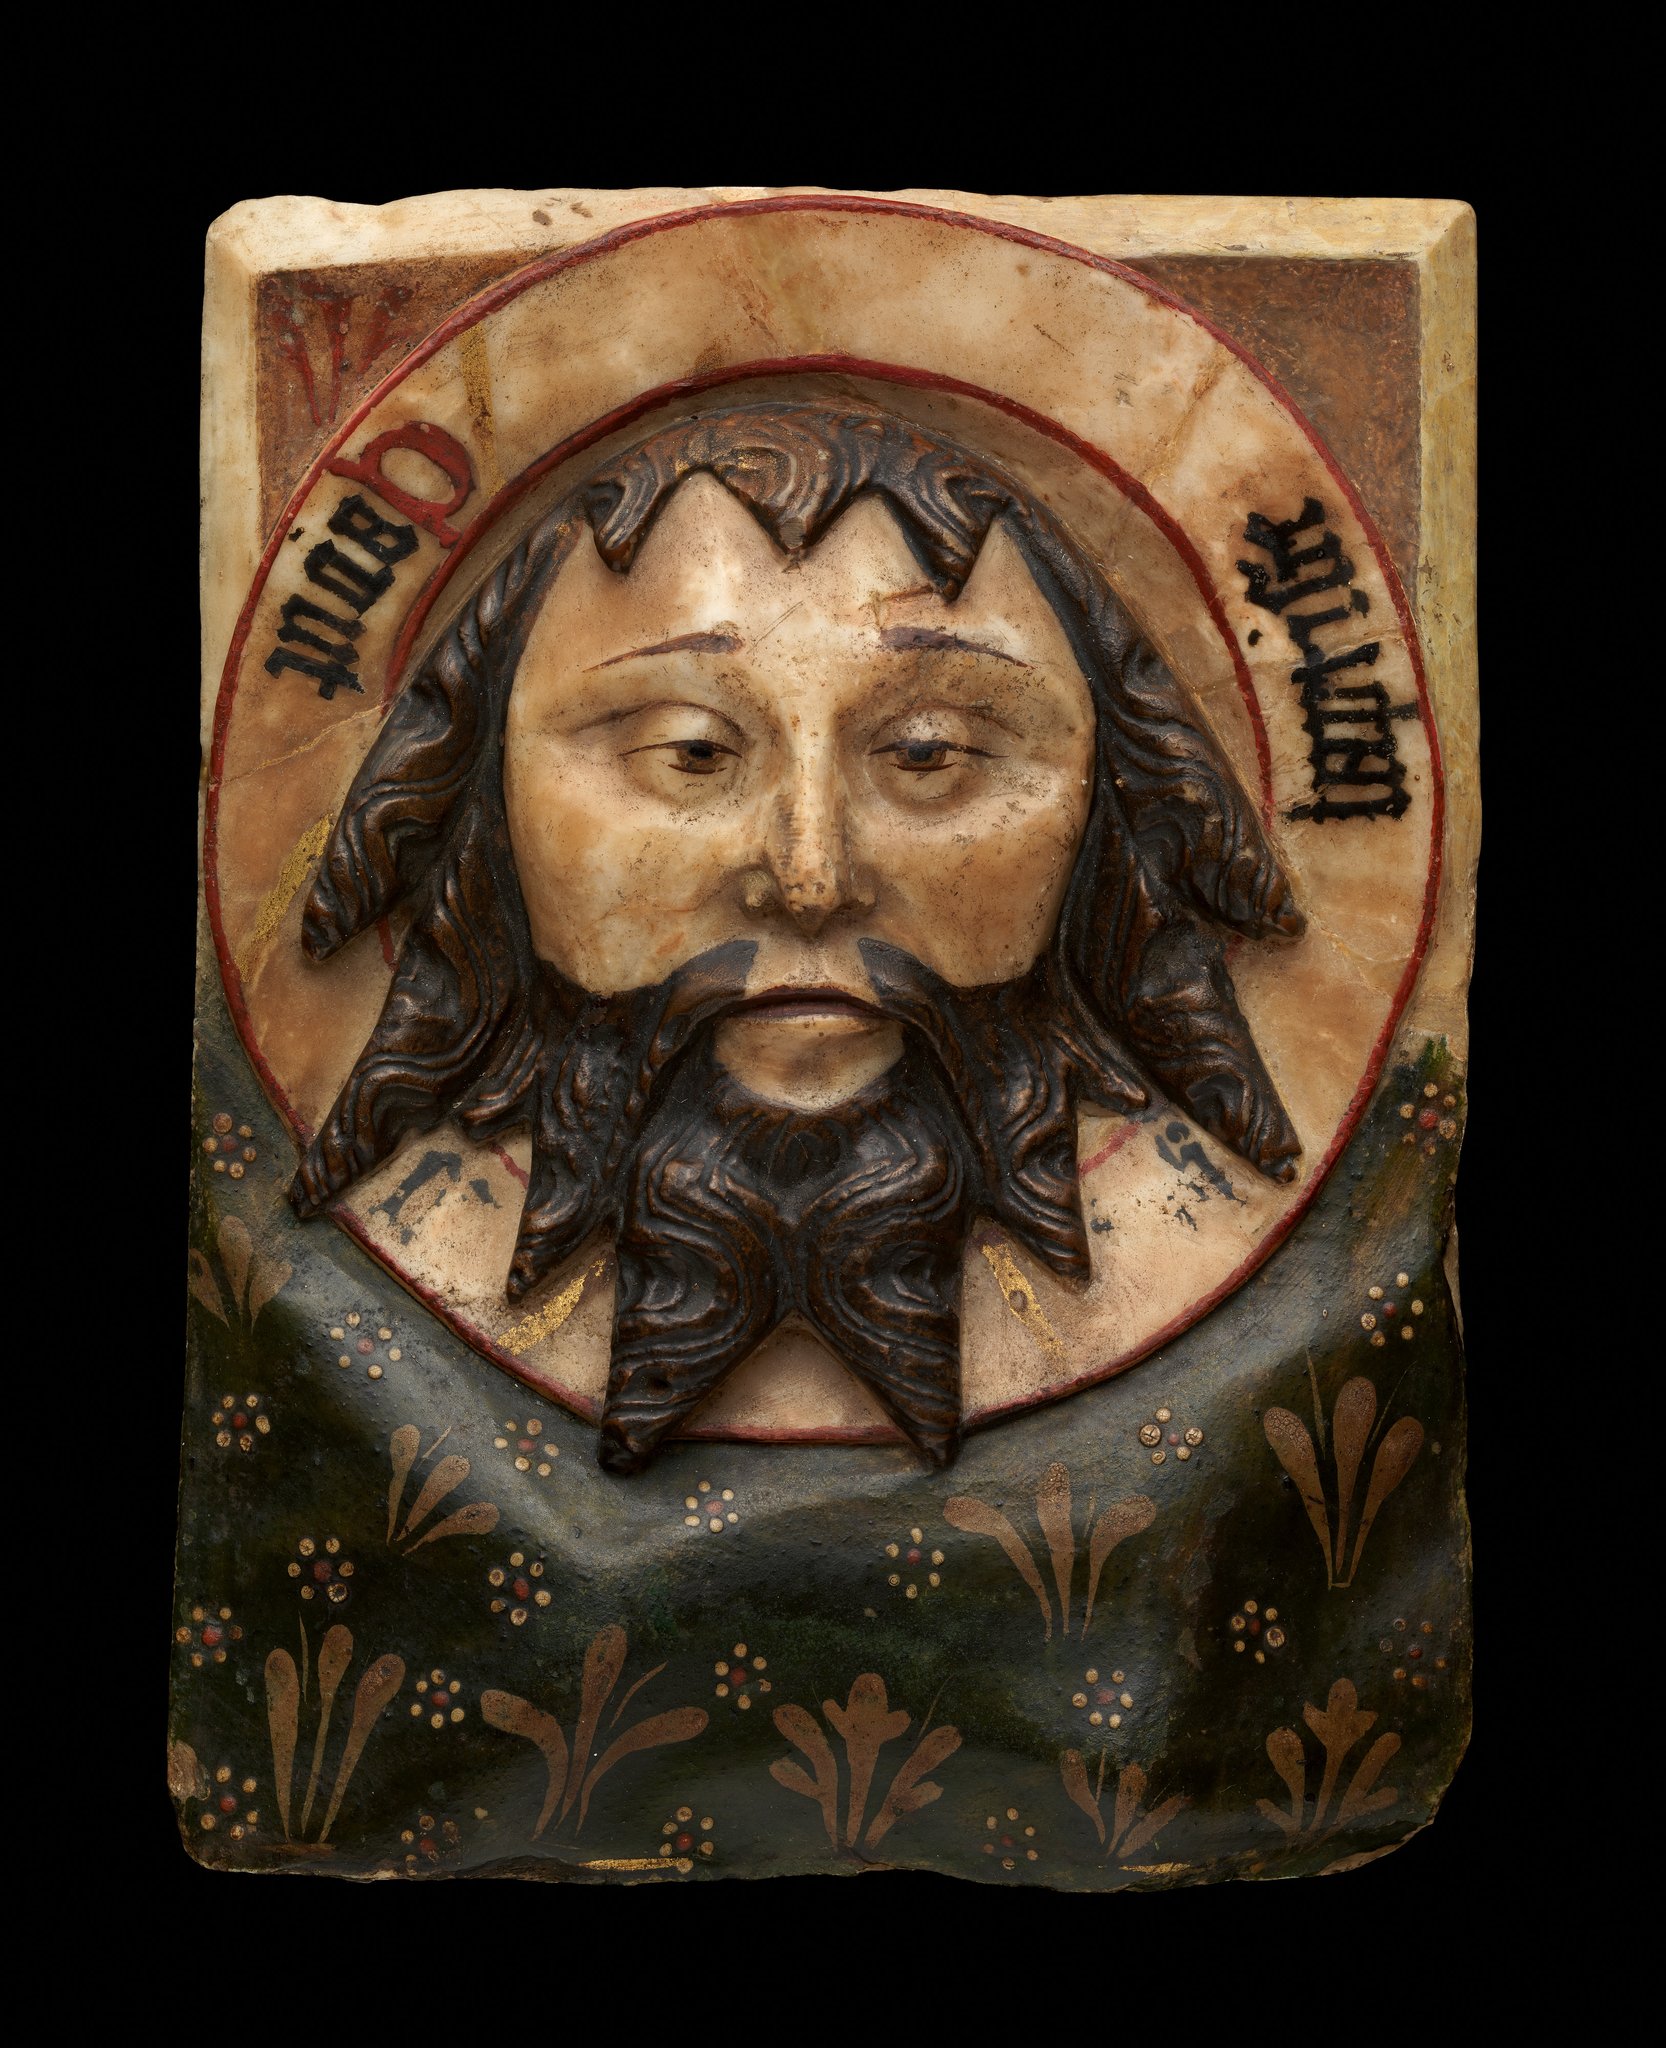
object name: plaque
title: Plaque with the Head of Saint John the Baptist on a Charger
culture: british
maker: school of nottingham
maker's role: artist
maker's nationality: british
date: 1401-1500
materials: alabaster, paint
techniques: gilding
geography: england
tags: heads